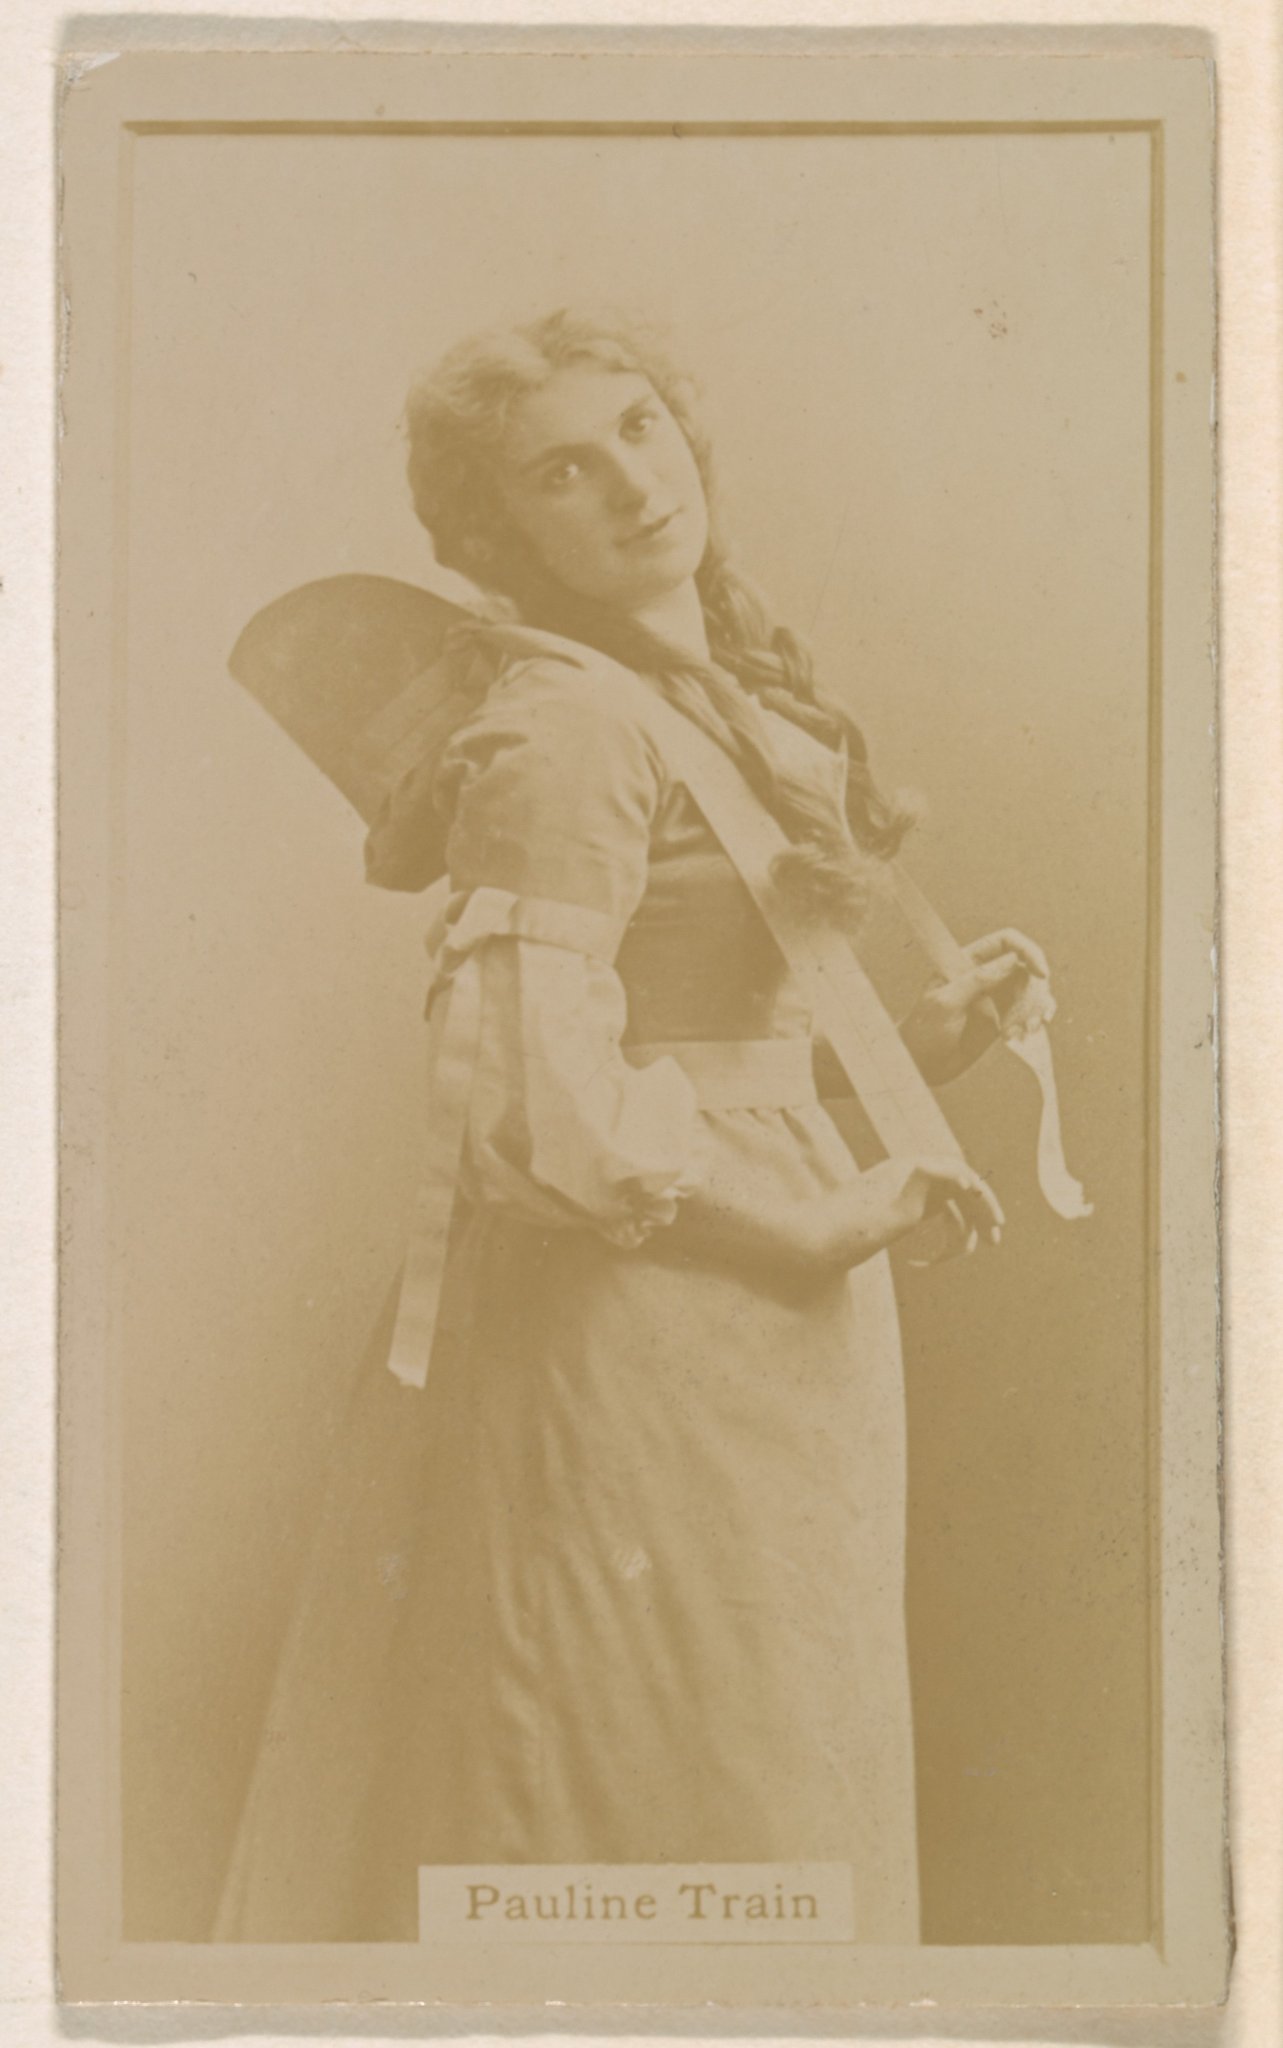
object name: photograph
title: Pauline Train, from the Actresses series (N245) issued by Kinney Brothers to promote Sweet Caporal Cigarettes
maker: kinney brothers tobacco company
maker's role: publisher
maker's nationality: american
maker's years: 1869-2011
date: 1890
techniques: albumen silver print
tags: portraits,women,actresses